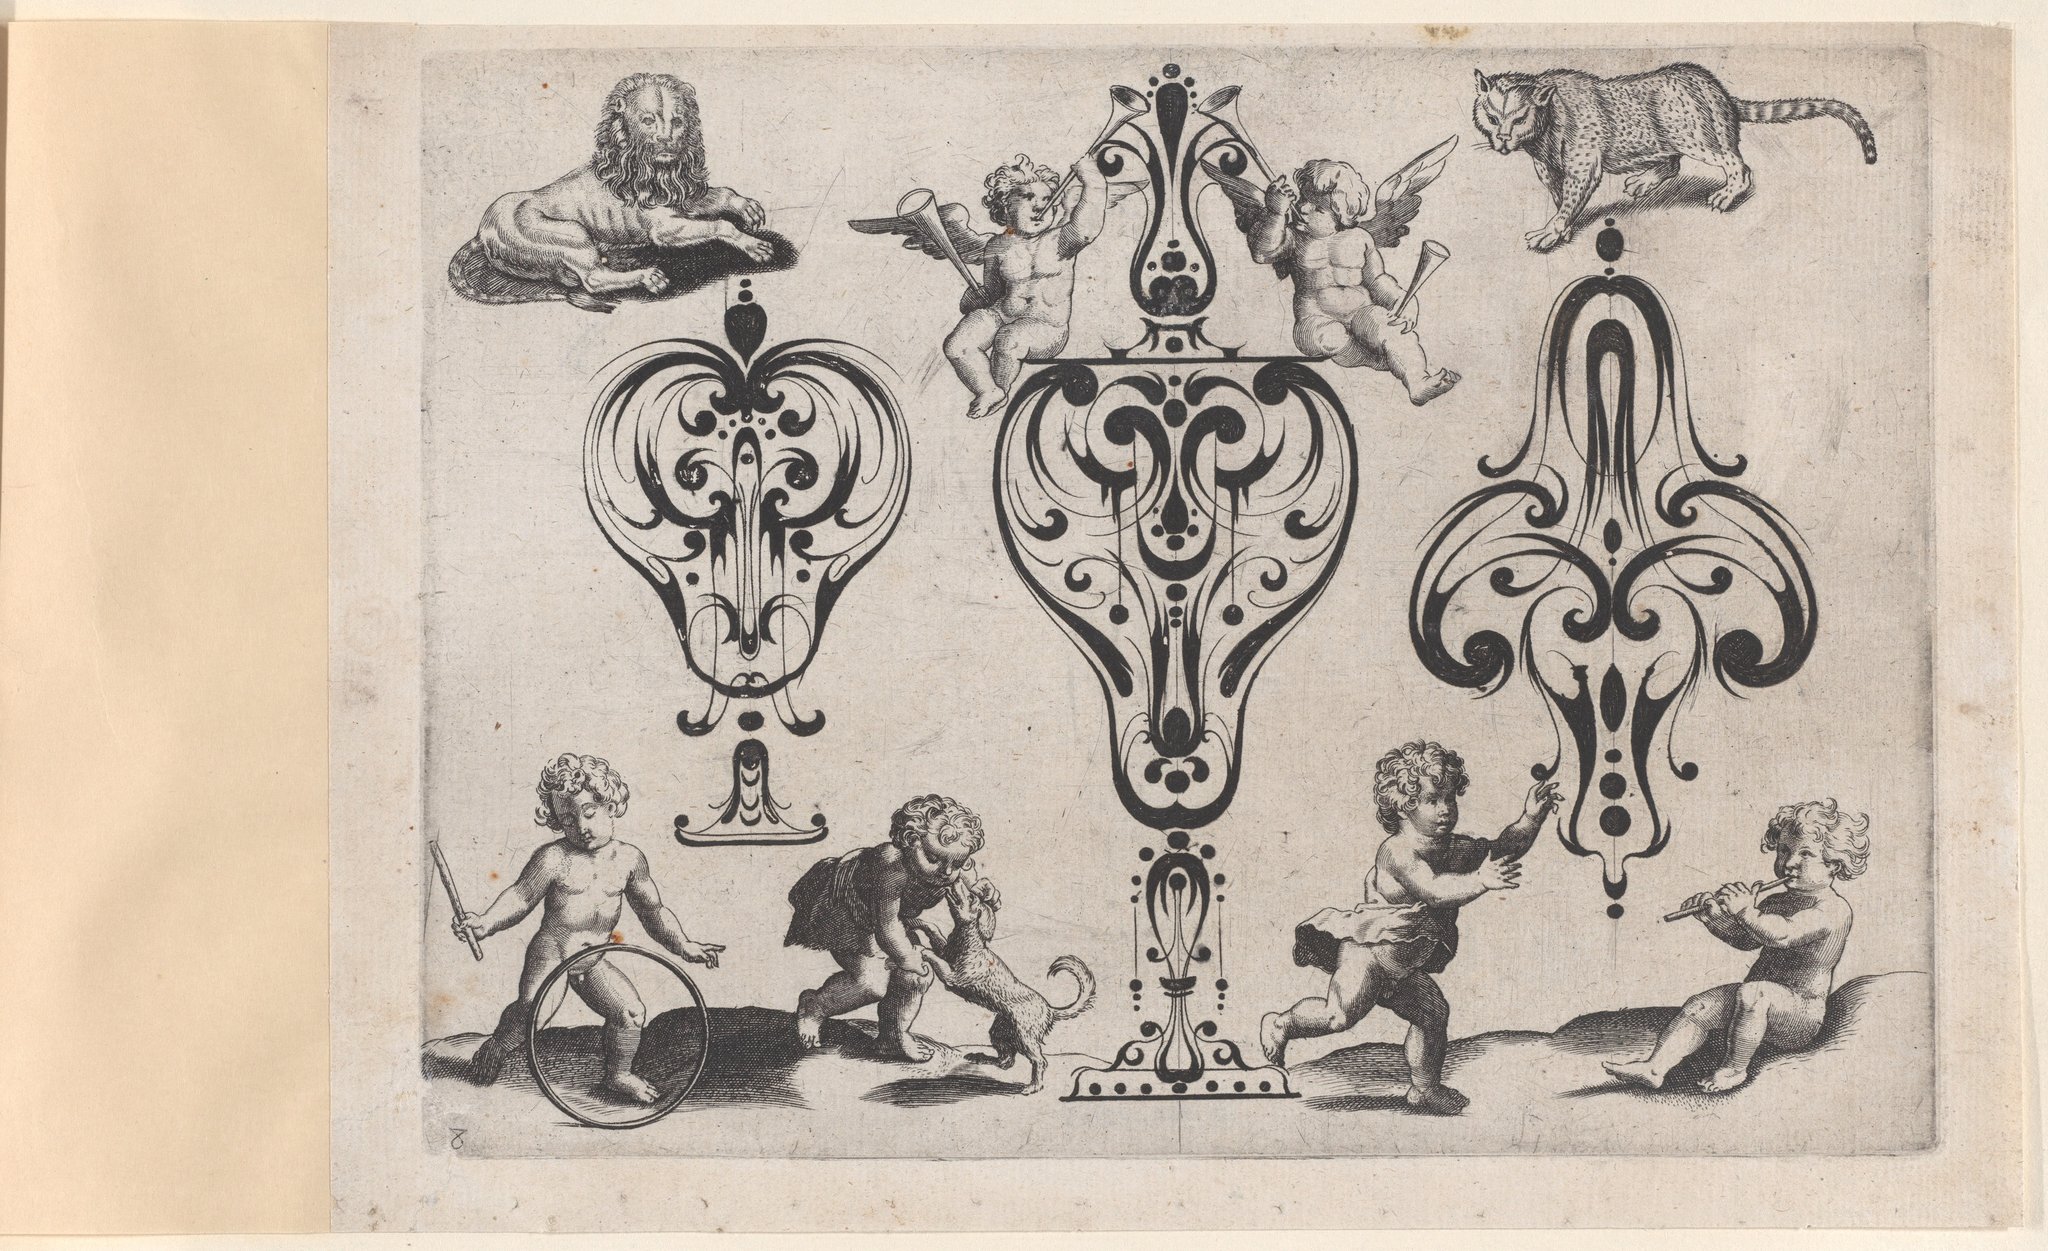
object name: album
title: Blackwork Designs with Putti and Felines, Plate 8 from a Series of Blackwork Ornaments combined with Figures, Birds, Animals and Flowers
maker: meinert gelijs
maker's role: artist and engraver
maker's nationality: dutch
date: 1622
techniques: embroidery, engraving